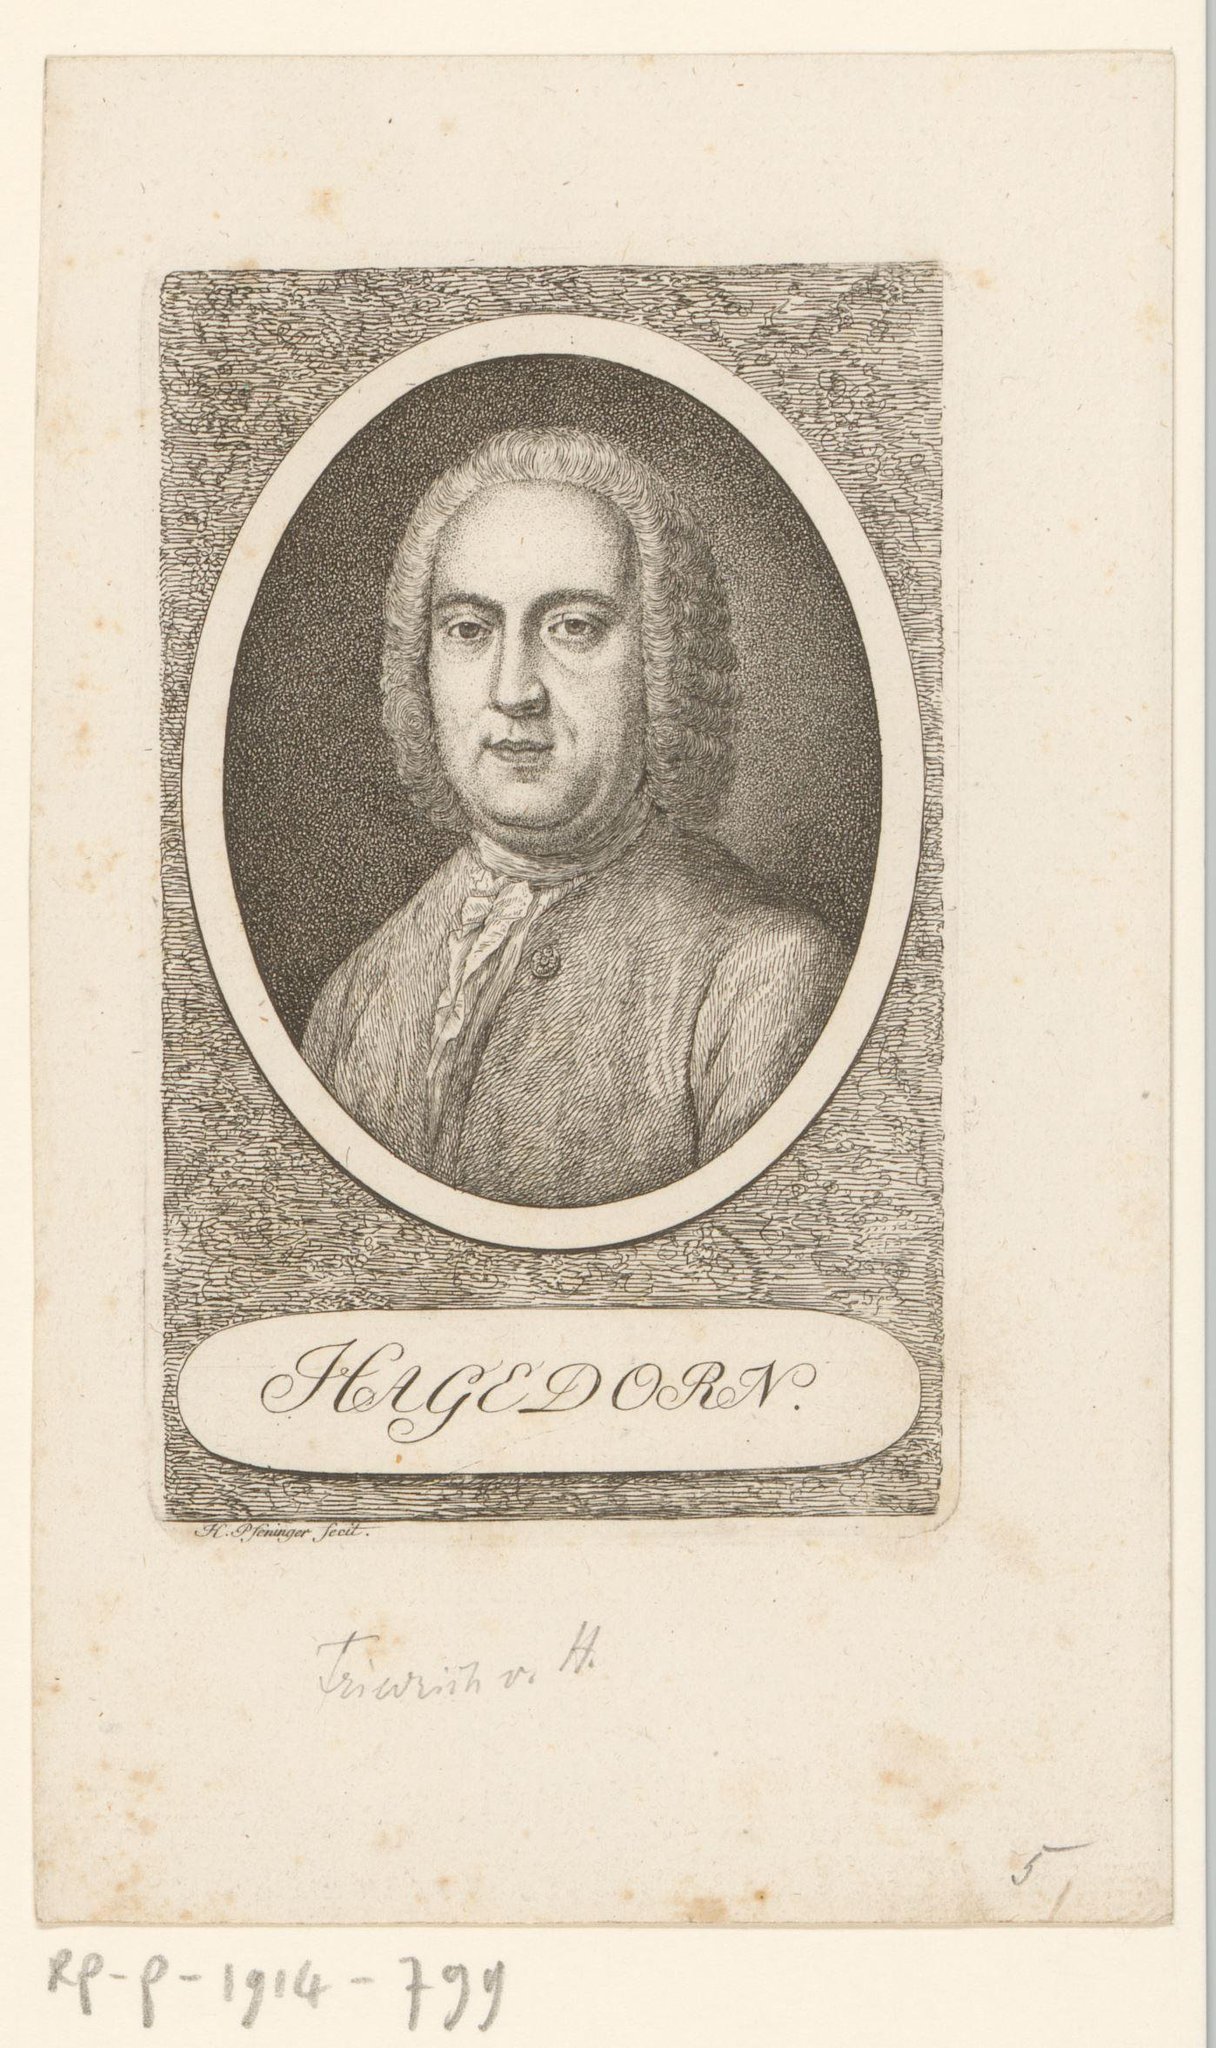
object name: print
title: Portret van Friedrich von Hagedorn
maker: heinrich pfenninger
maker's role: print maker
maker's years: 1749-1815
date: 1759-1815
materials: paper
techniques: etching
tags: historical persons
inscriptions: name, number: ‘5’, collector's mark: Lugt 2228